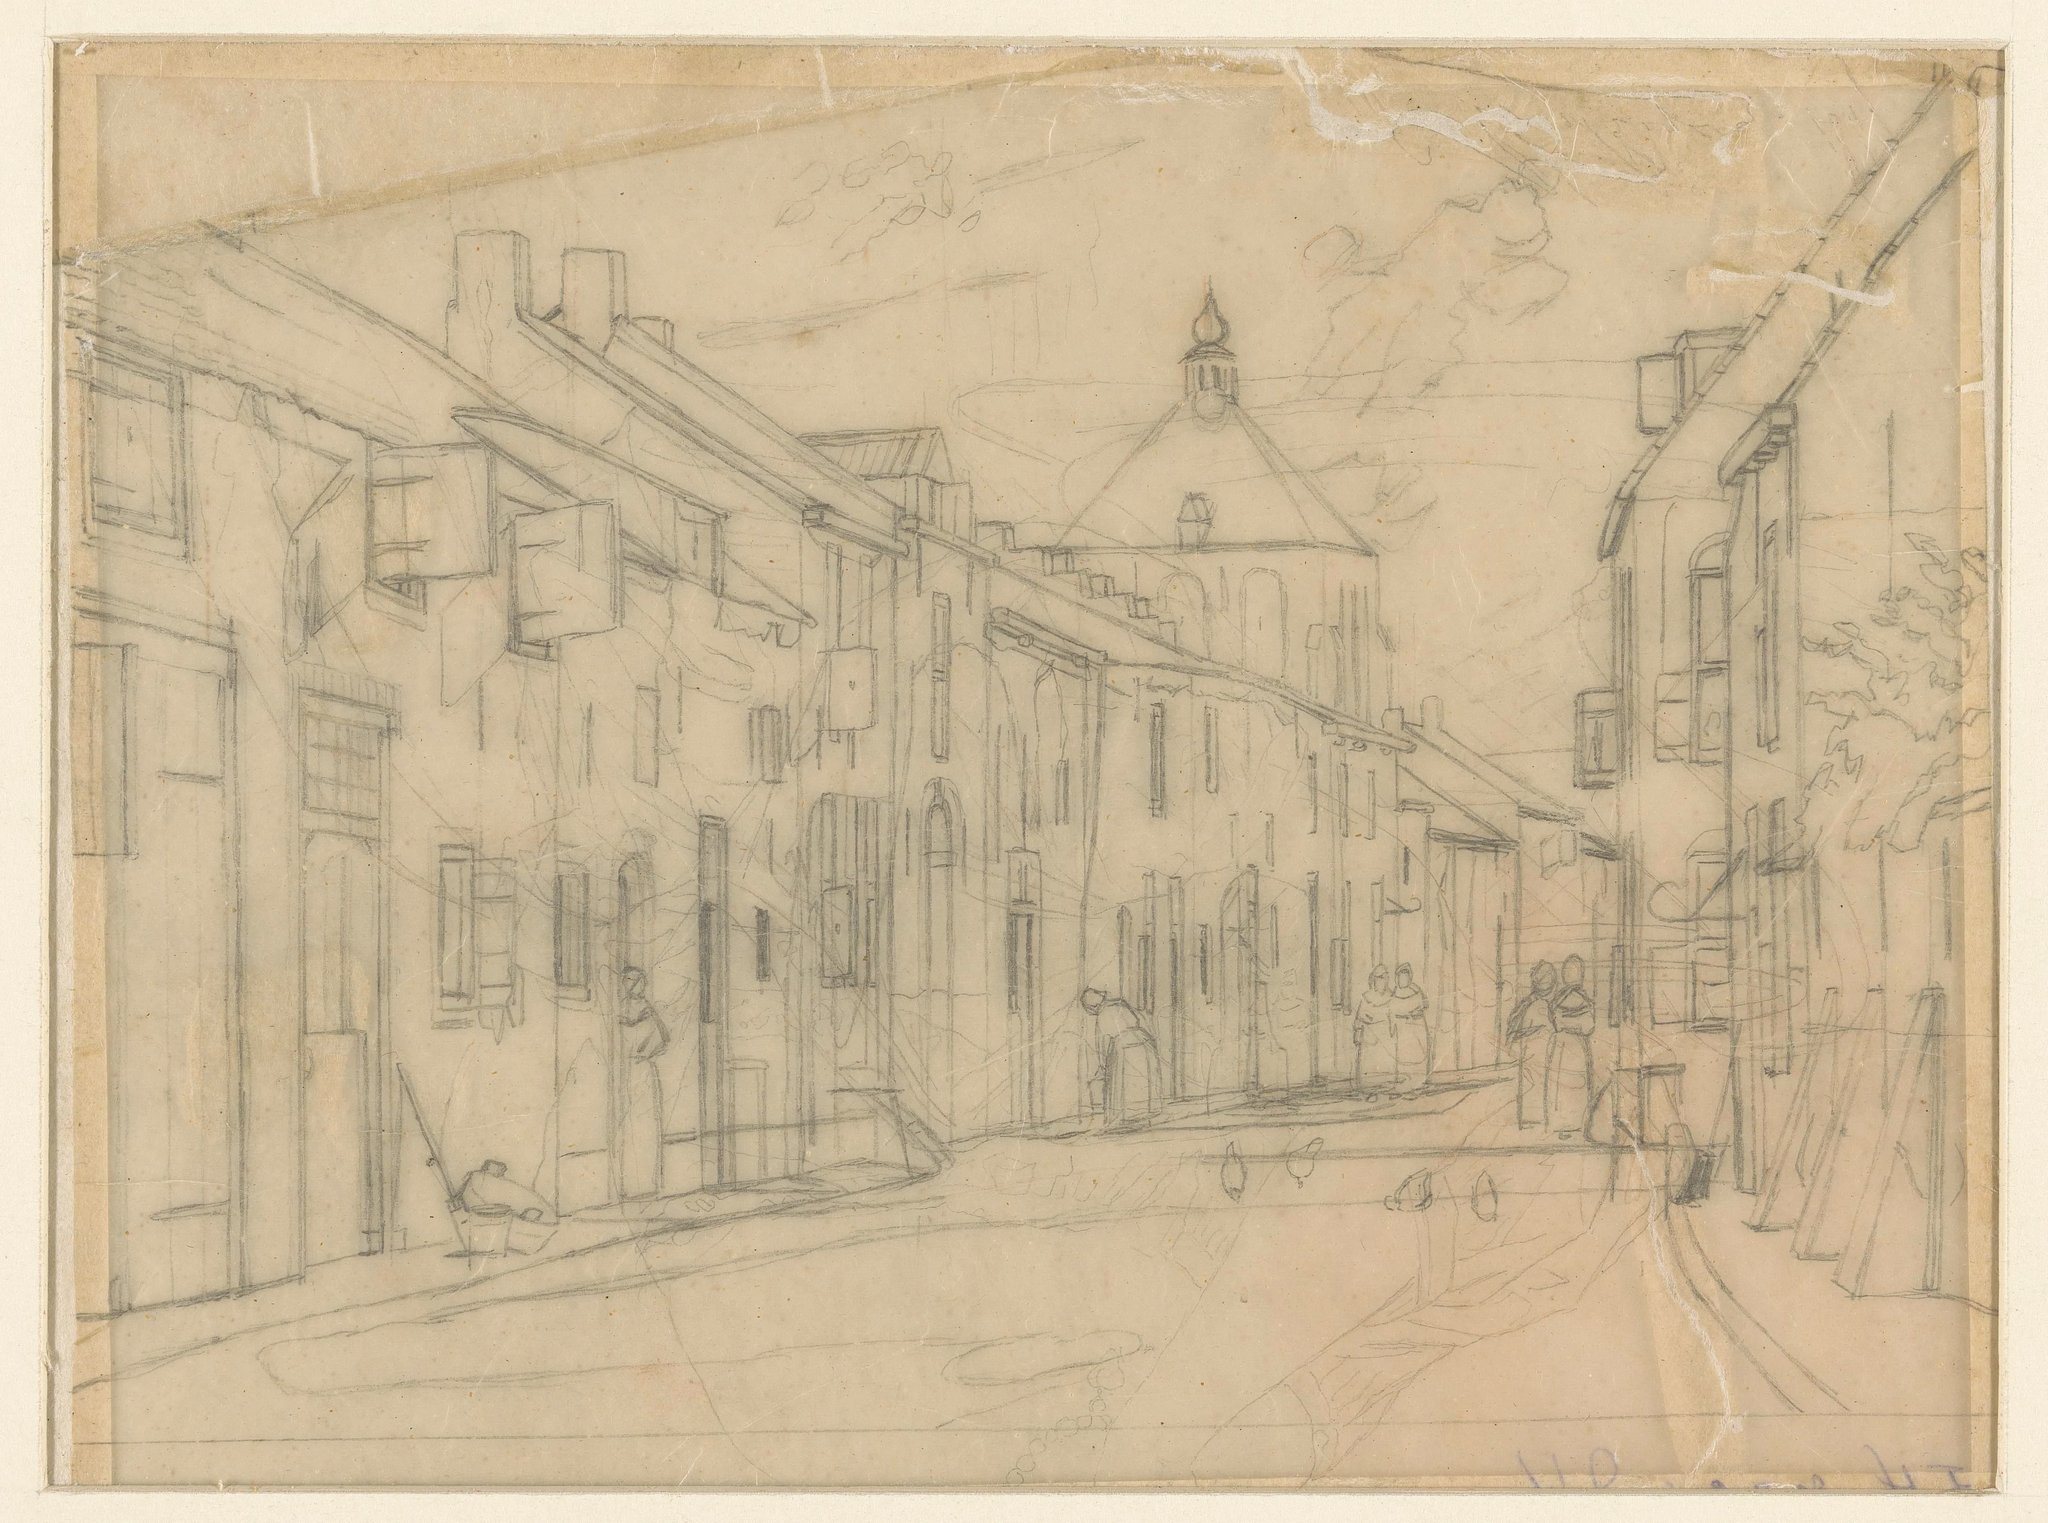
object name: drawing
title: Dorpsstraat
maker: frederik hendrik weissenbruch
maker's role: draughtsman, print maker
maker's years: 1828-1887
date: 1838-1887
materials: pencil, paper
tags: prospect of village, silhouette of village